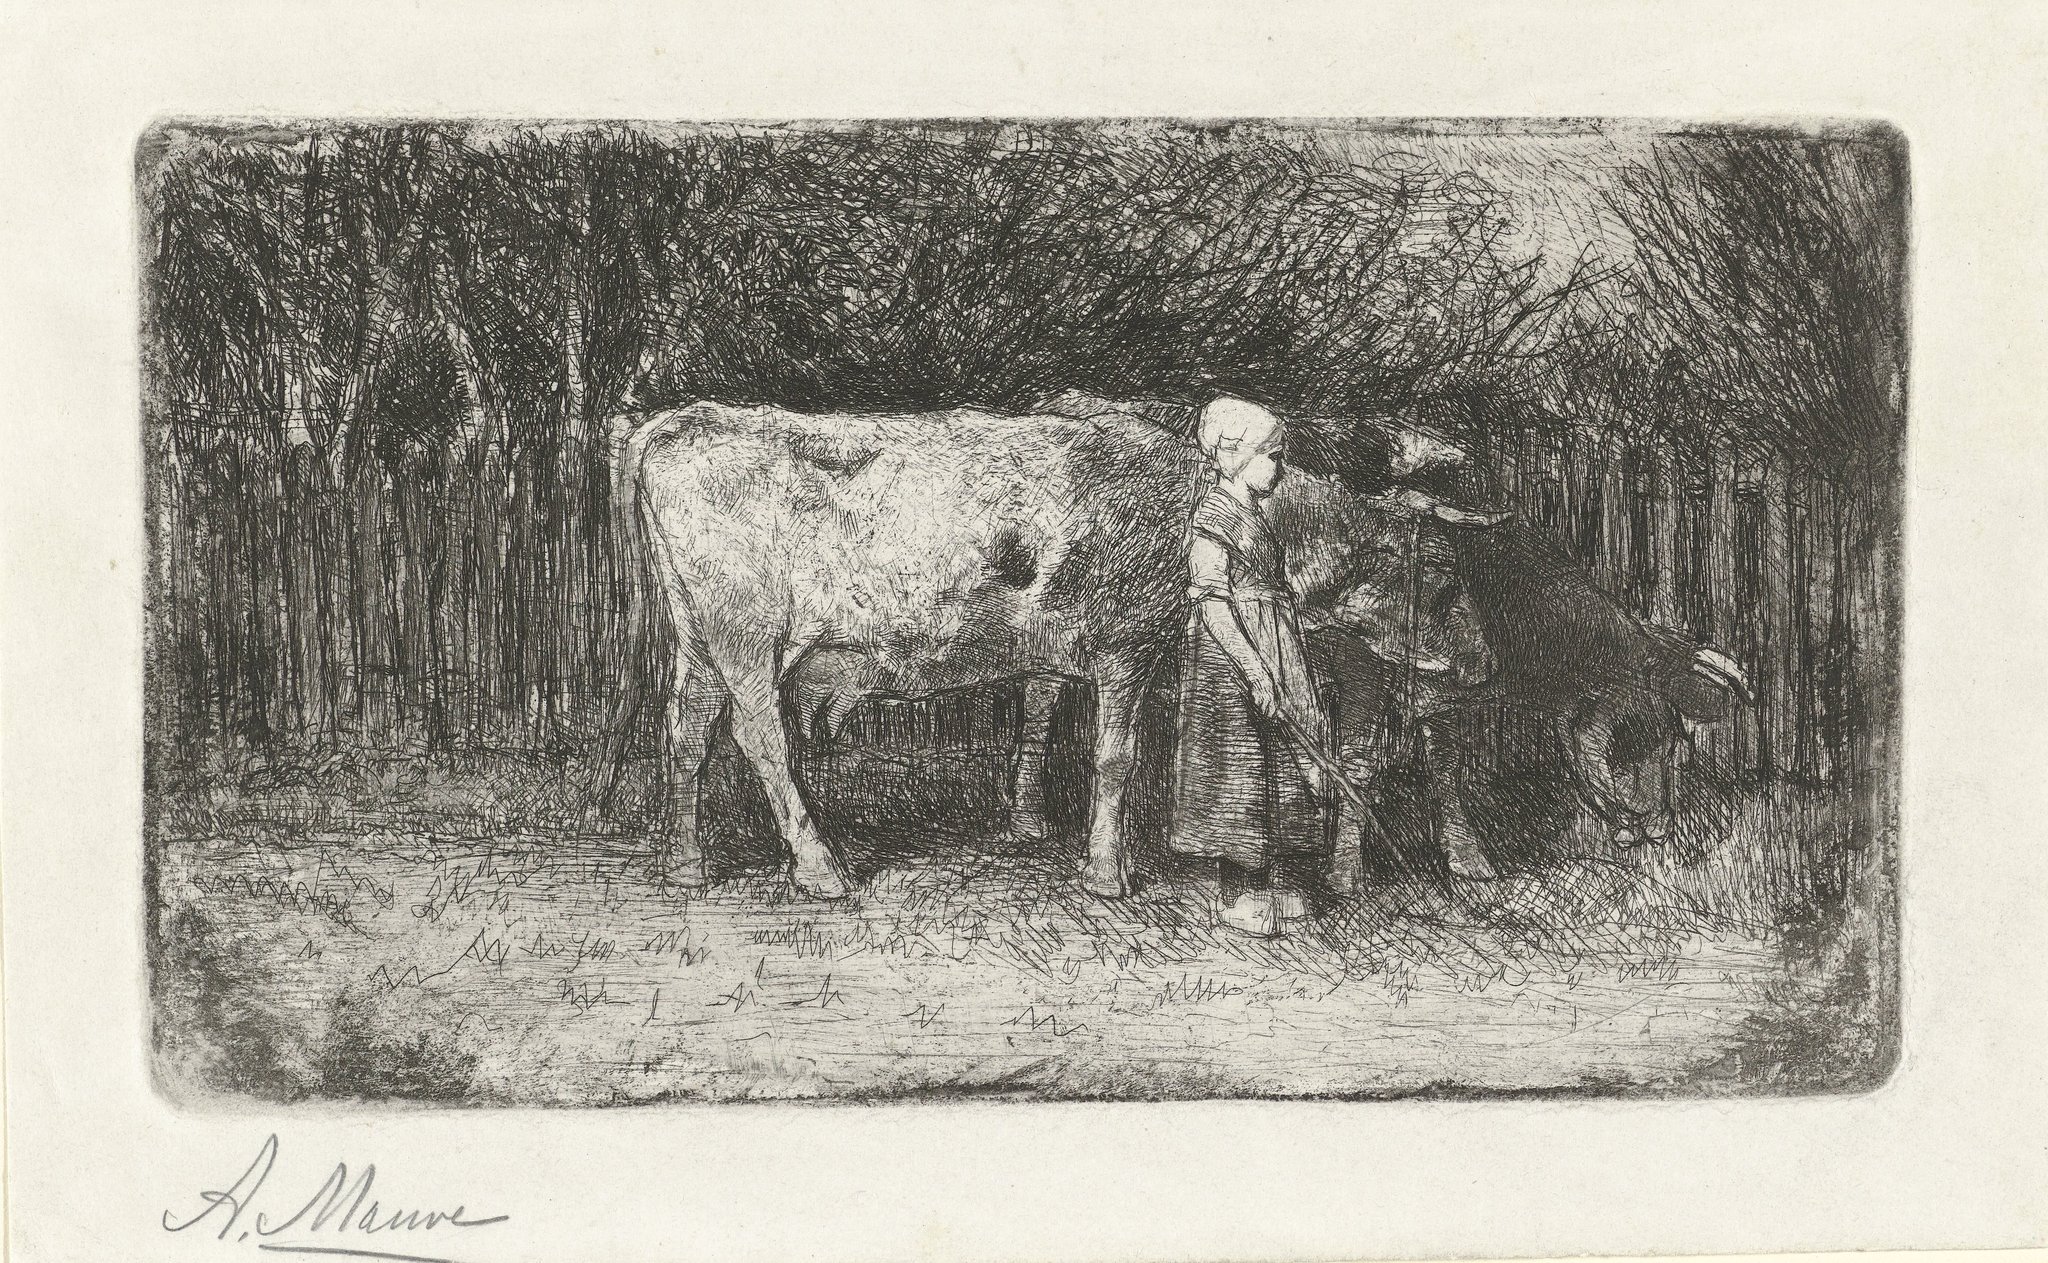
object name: print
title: Meisje bij de koeien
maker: anton mauve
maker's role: draughtsman, painter, print maker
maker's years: 1838-1888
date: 1848-1888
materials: paper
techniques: etching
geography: netherlands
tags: cow, girl (child between toddler and youth)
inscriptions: collector's mark: Lugt 2228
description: Een meisje met een kapje op het hoofd en een stok in de hand staat naast twee koeien. Op de achtergrond een hek.